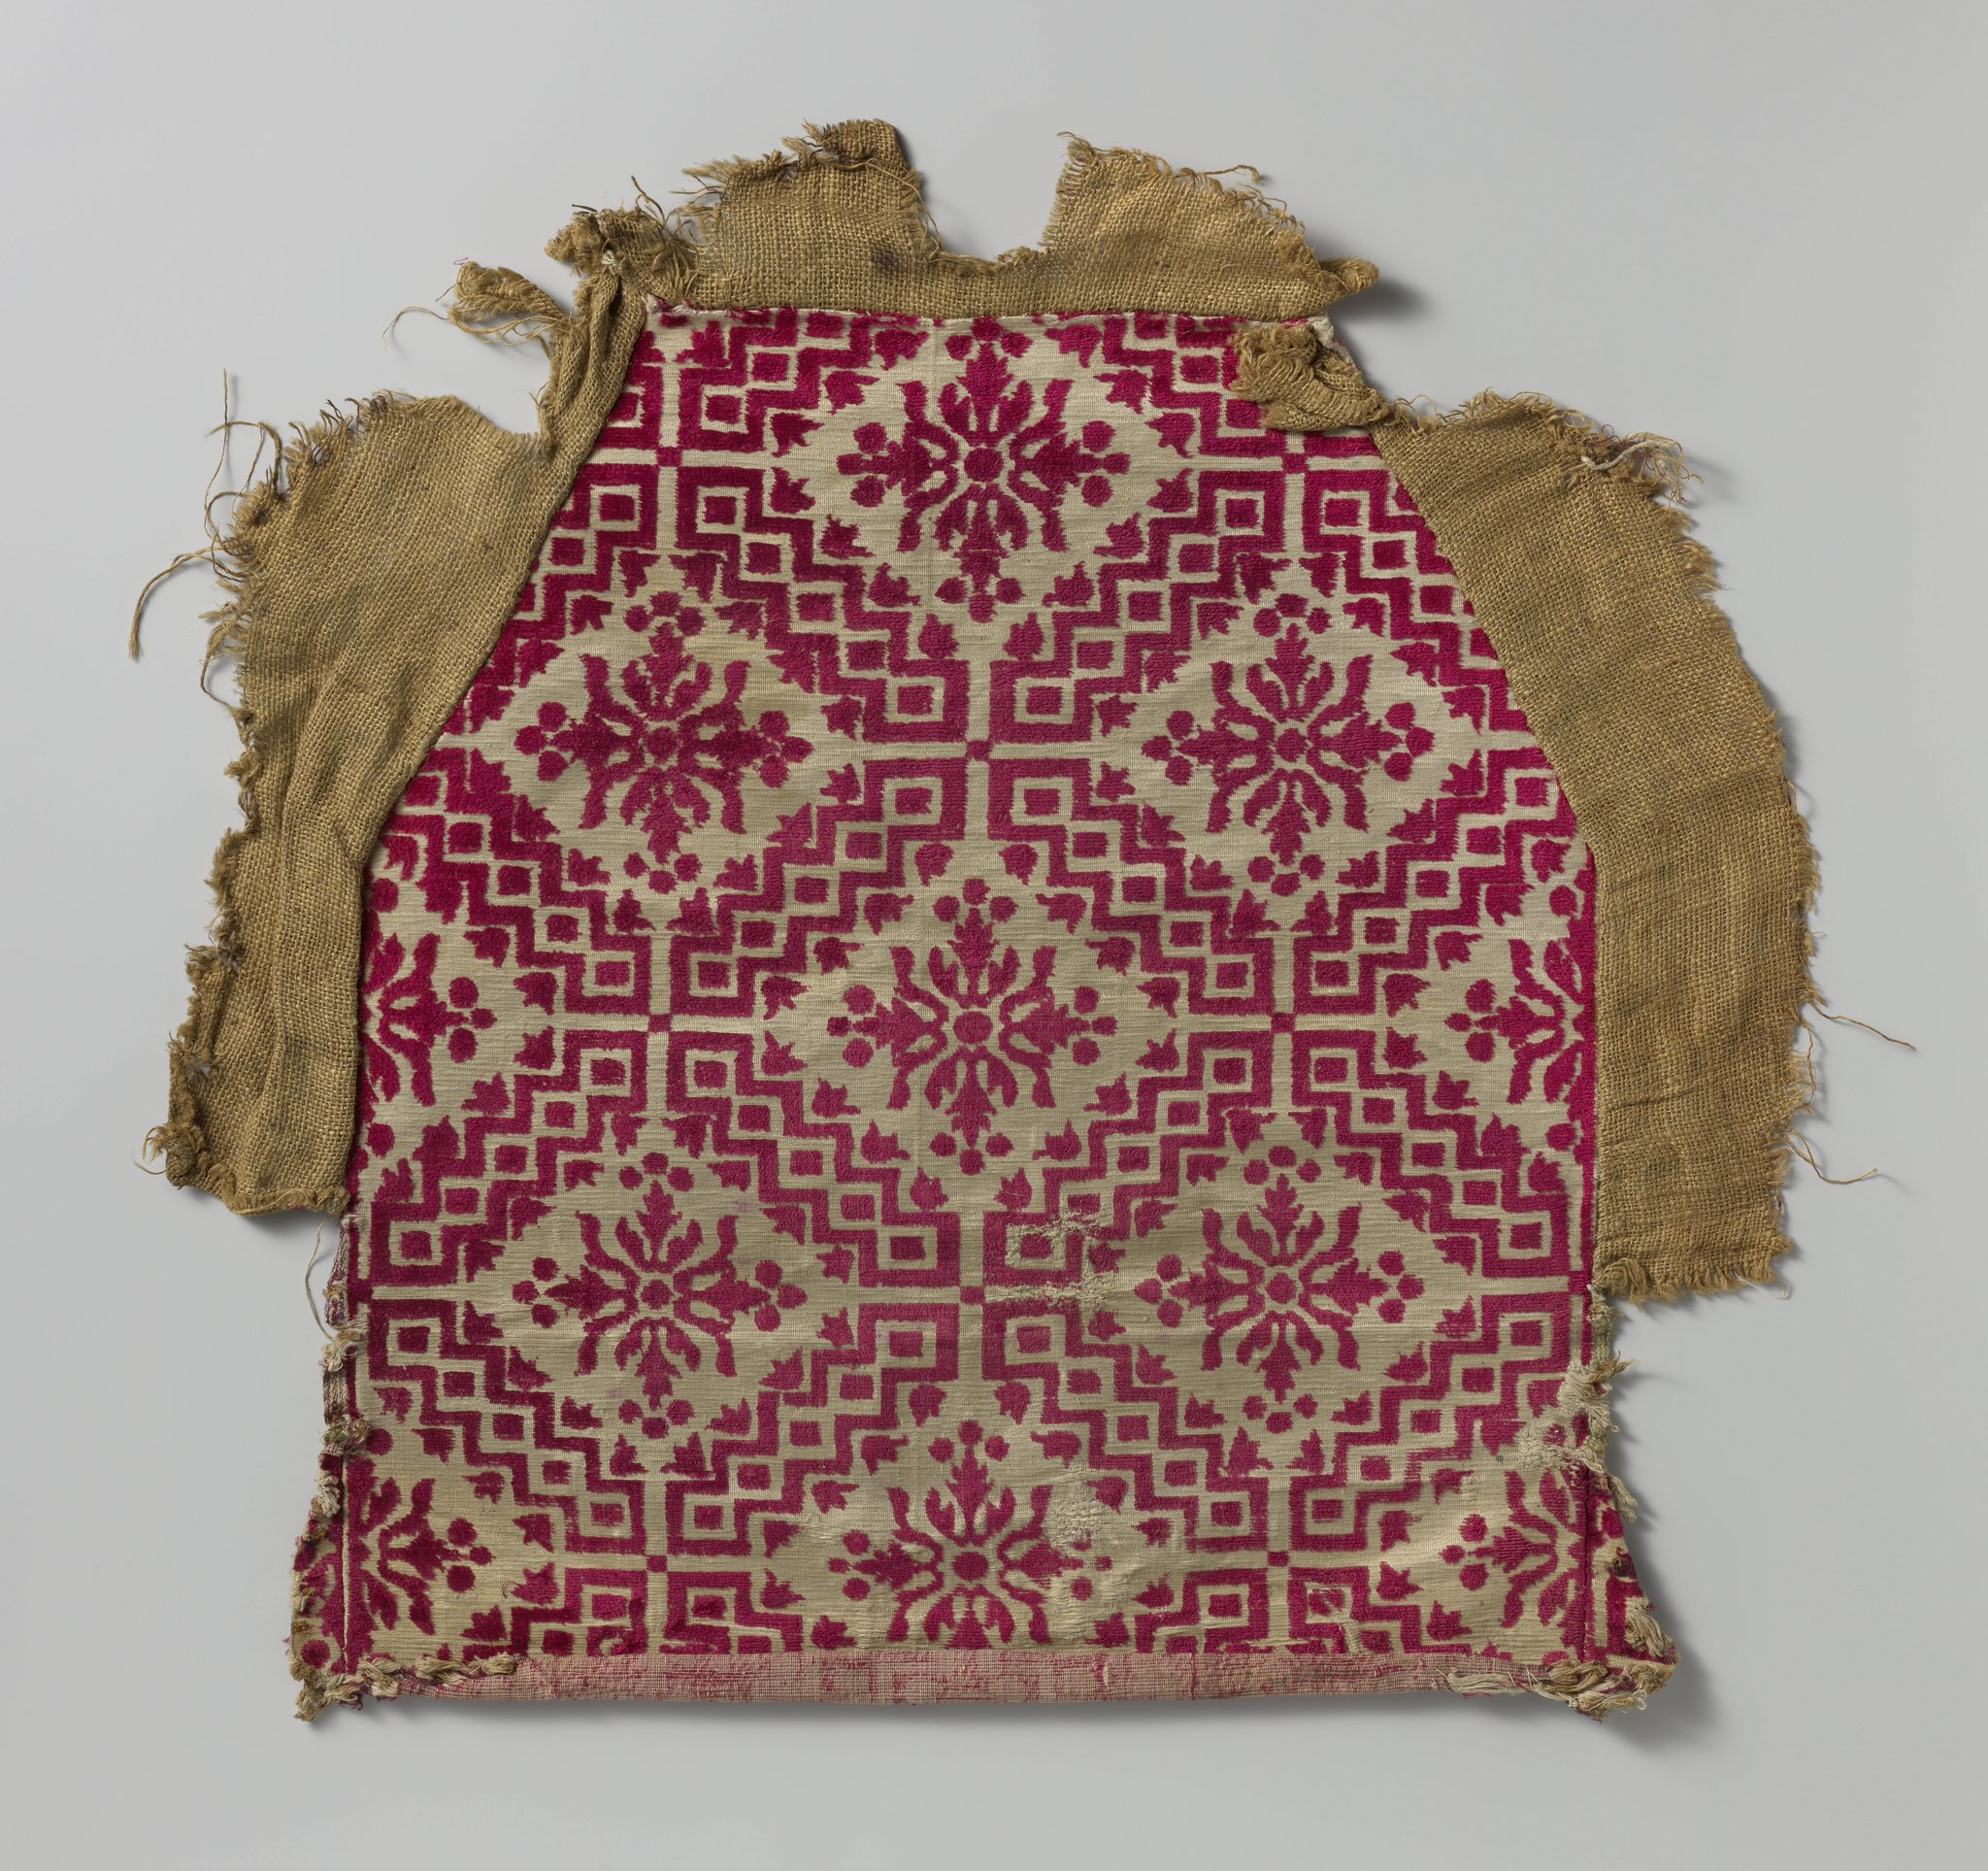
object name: stressed skin structure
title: Fragment stoelbekleding in rood en wit fluweel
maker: Anonymous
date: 1600-1699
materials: cotton, silk, velvet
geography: western europe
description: Rugstuk van een stoelbekleding van geciseleerd zijden fluweel.